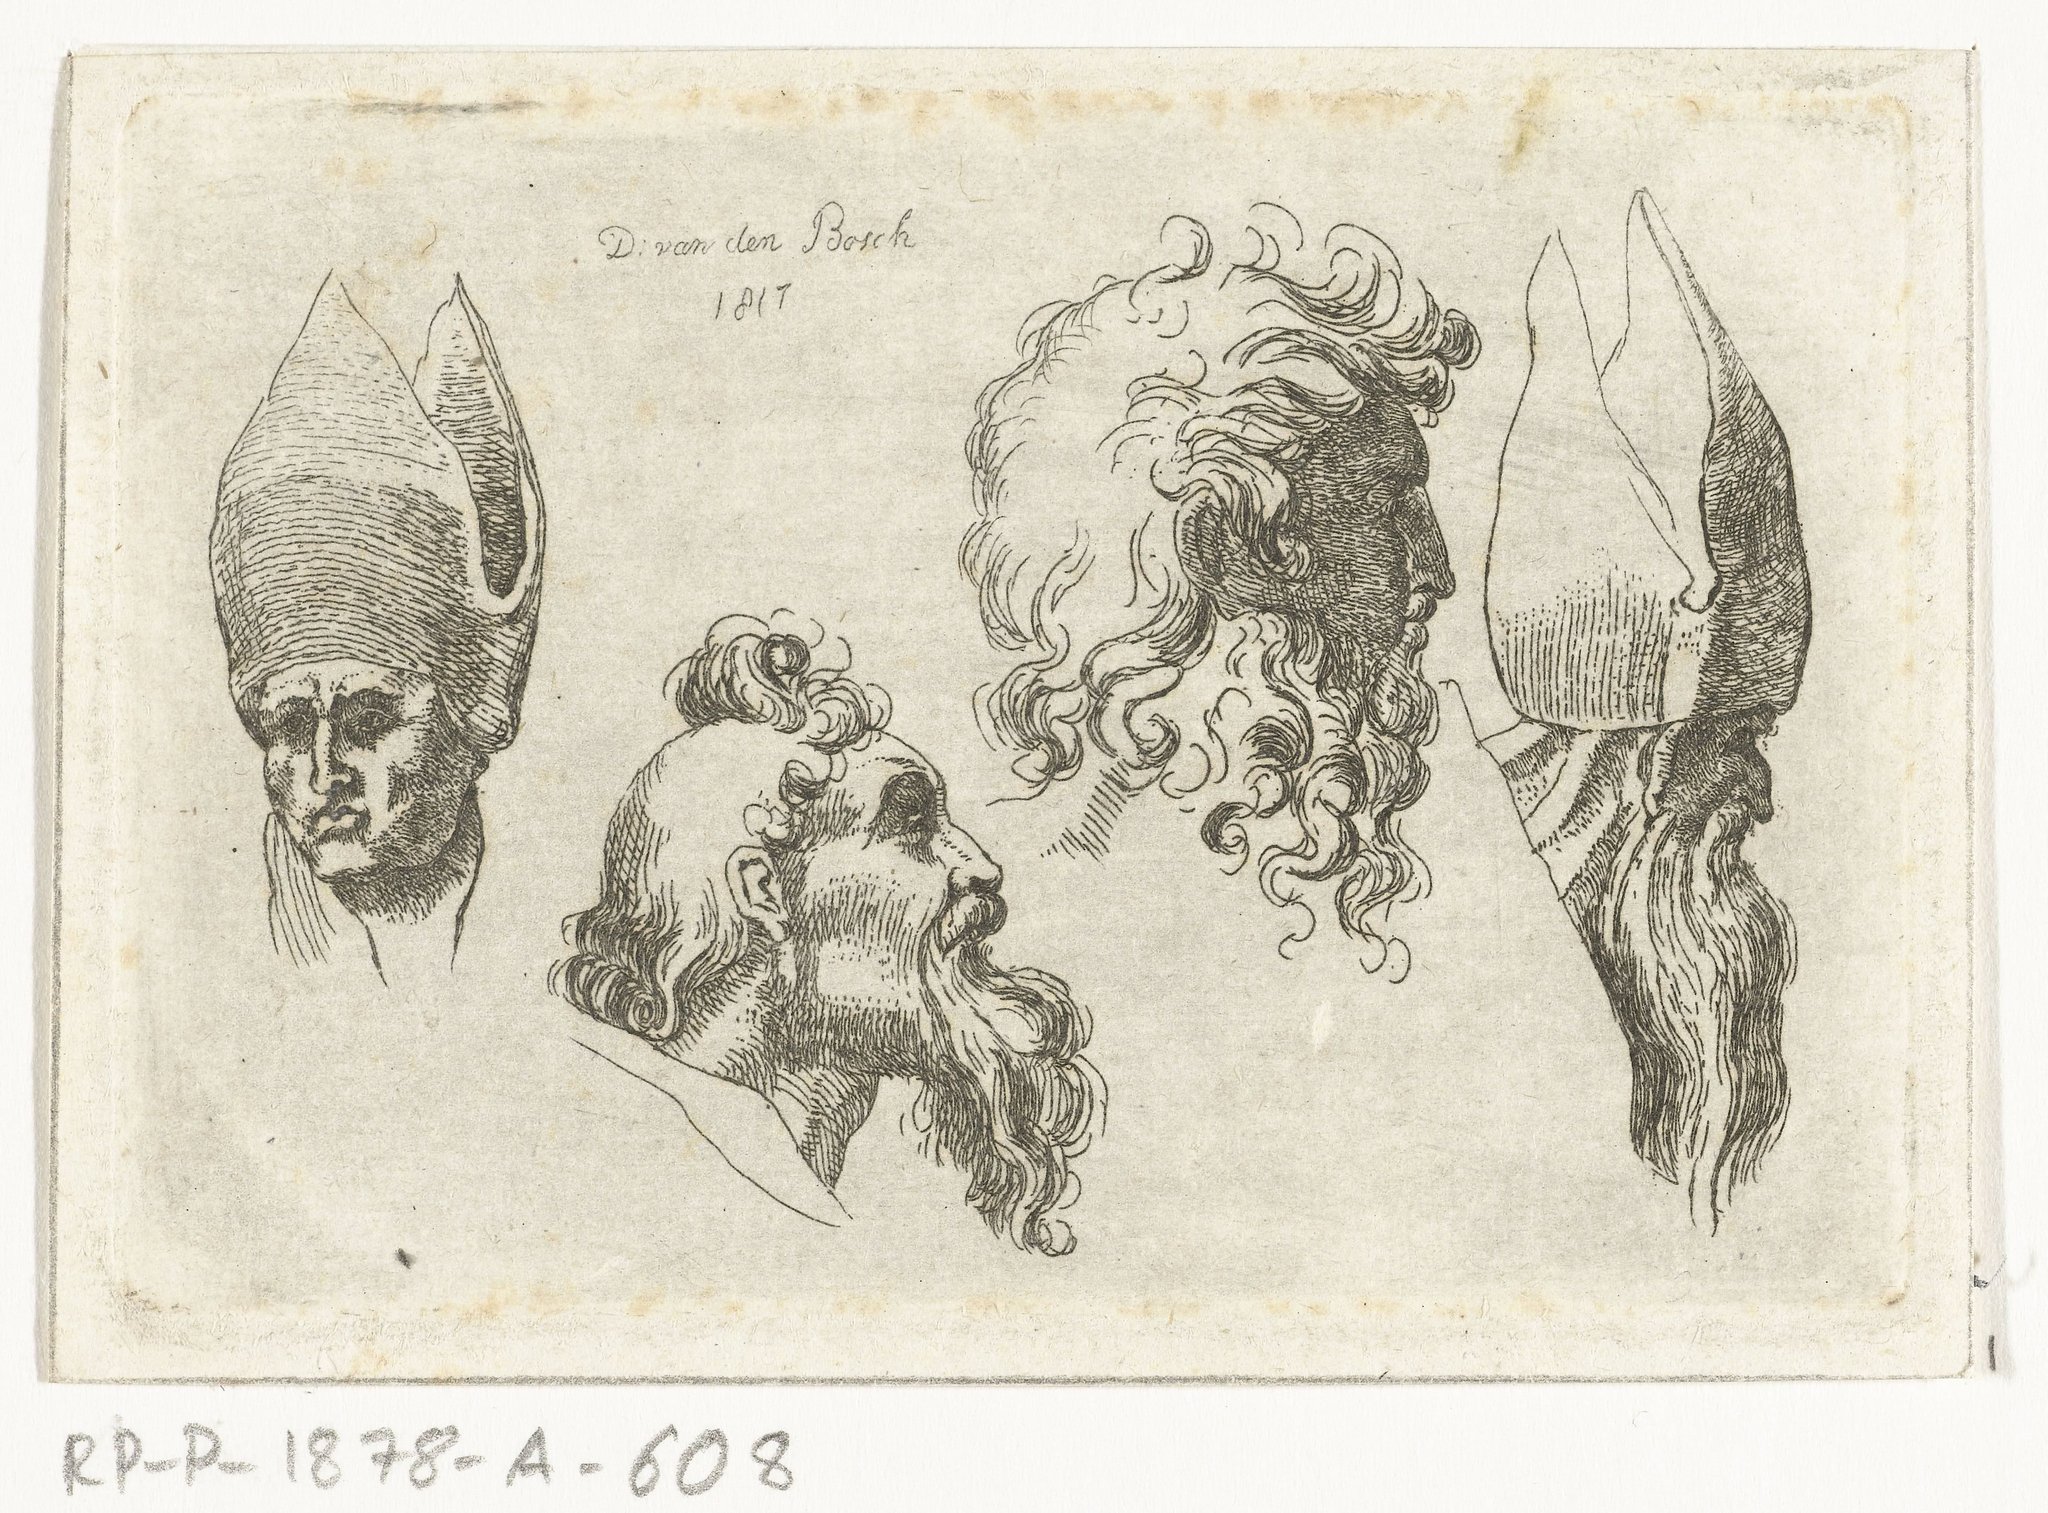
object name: print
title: Studieblad met vier hoofden, waarvan twee met een mijter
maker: d. van den bosch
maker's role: print maker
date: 1817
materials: paper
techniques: aquatint, etching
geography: netherlands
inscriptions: collector's mark: Lugt 2227